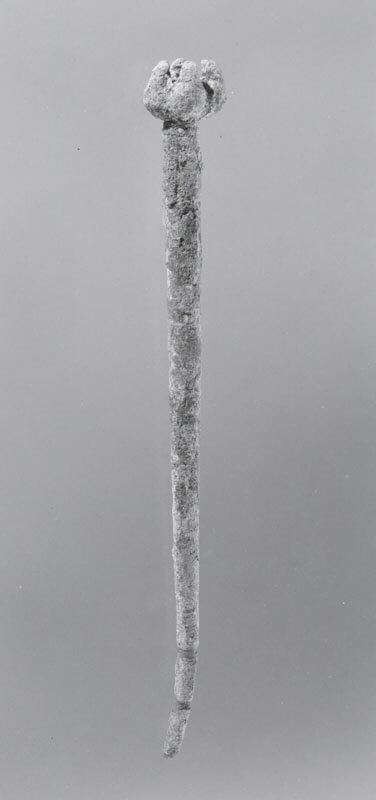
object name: pin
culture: bactria-margiana archaeological complex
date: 2333-1668 BCE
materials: copper alloy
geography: bactria-margiana